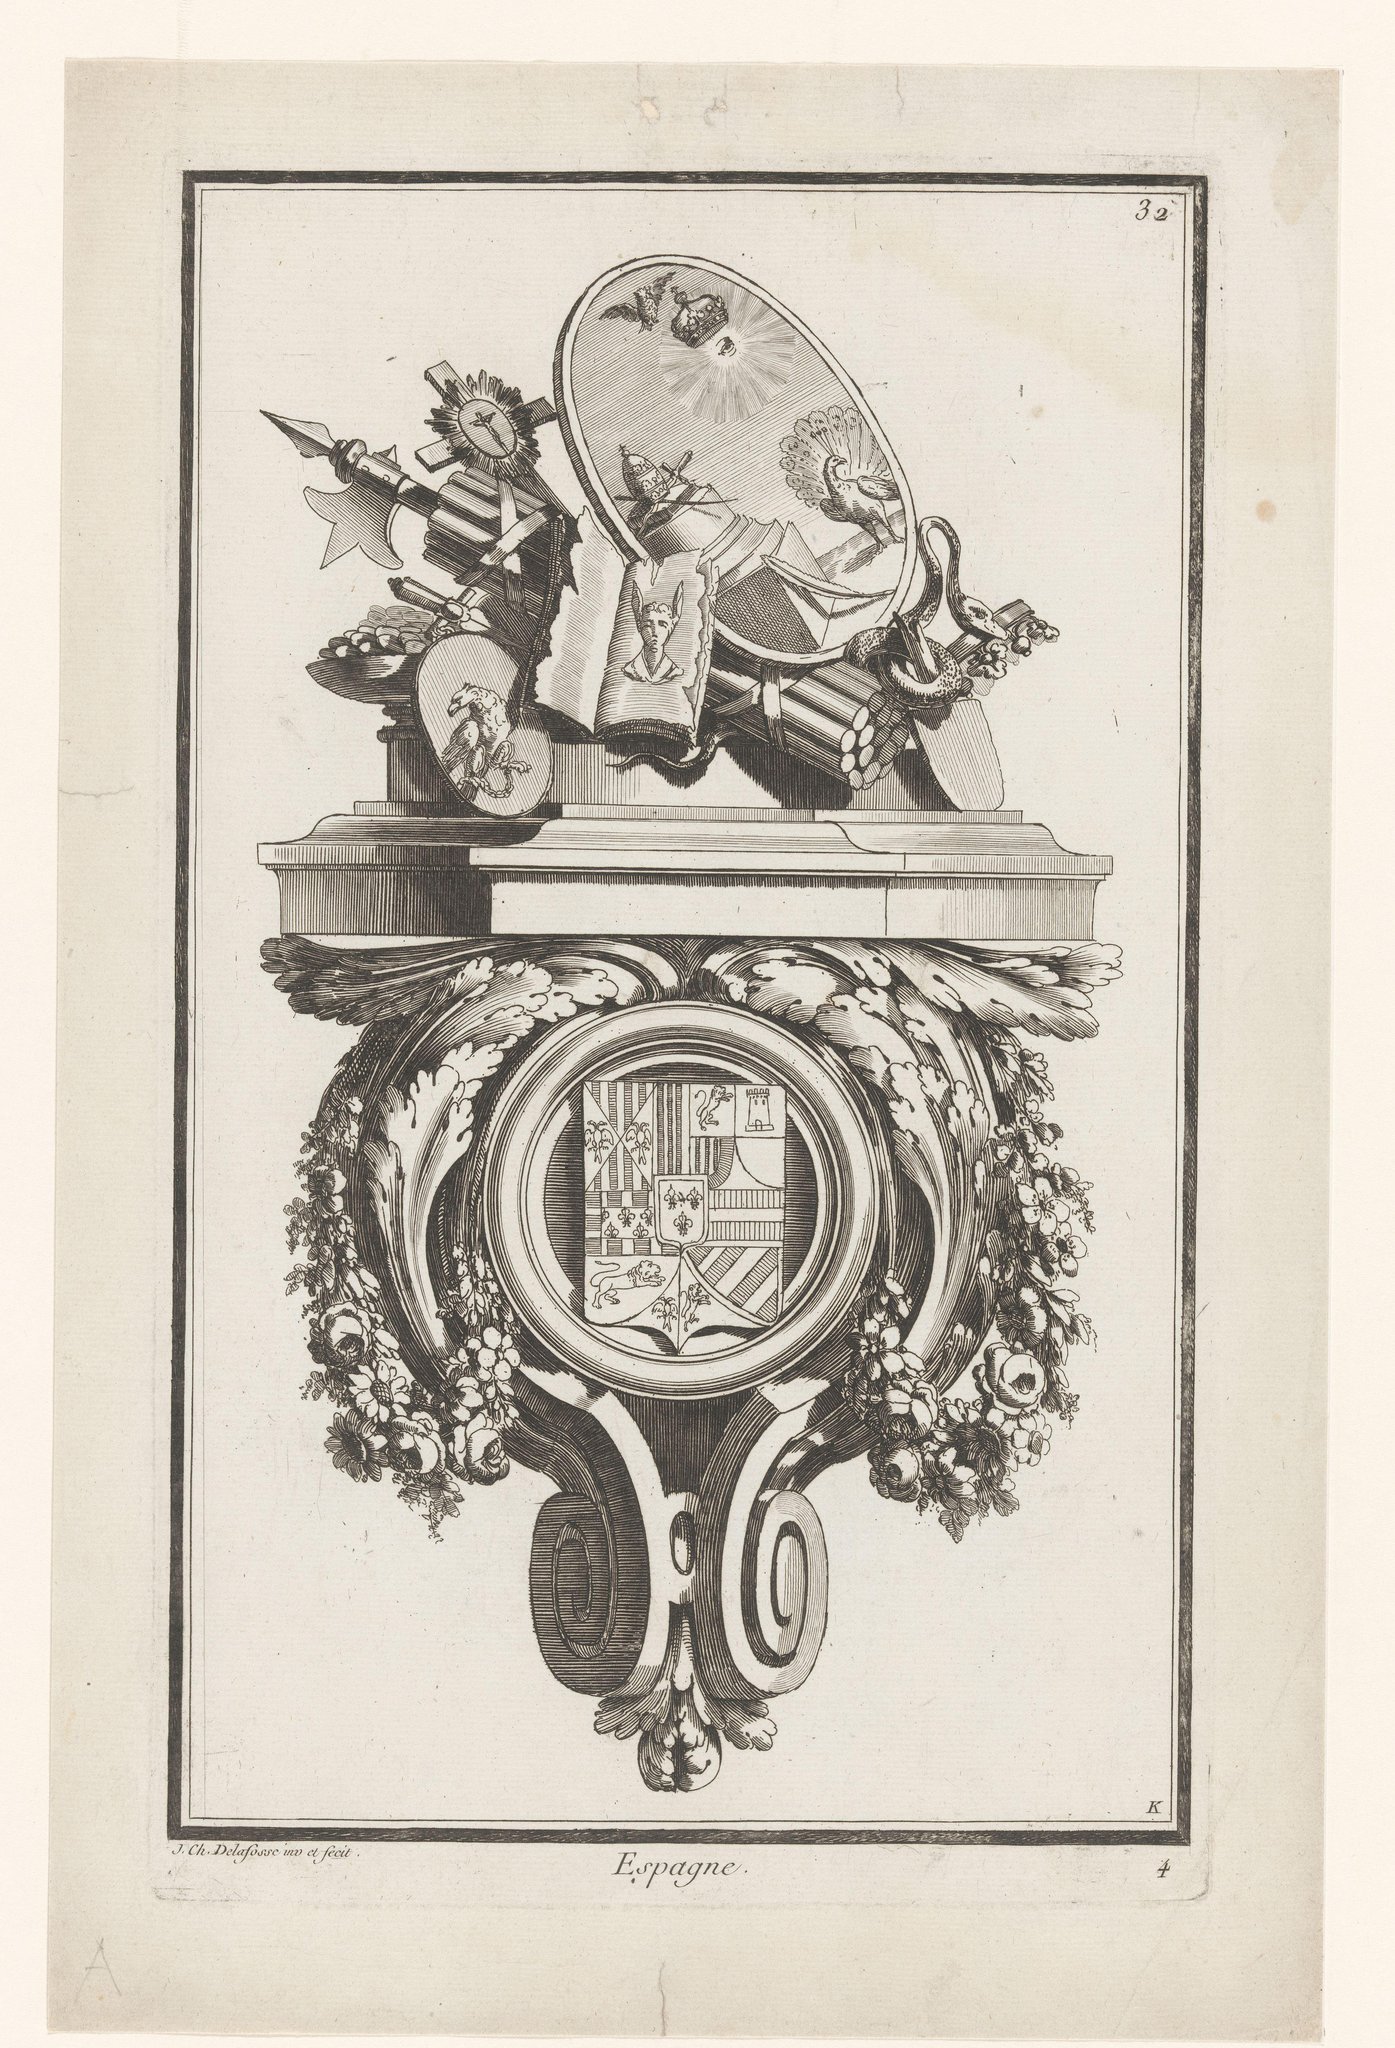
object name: print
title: Espagne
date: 1768-1771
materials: paper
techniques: engraving, etching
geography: paris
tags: other architectural details (console), spain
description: Een geornamenteerde console met guirlandes en een wapenschild, daarboven wapens, een kruis, een medaillon met een geketende adelaar, een slang met een kroon en een schep en een rond medaillon met een pauw en de pauselijke tiara op een basement. Prentnummer 32.